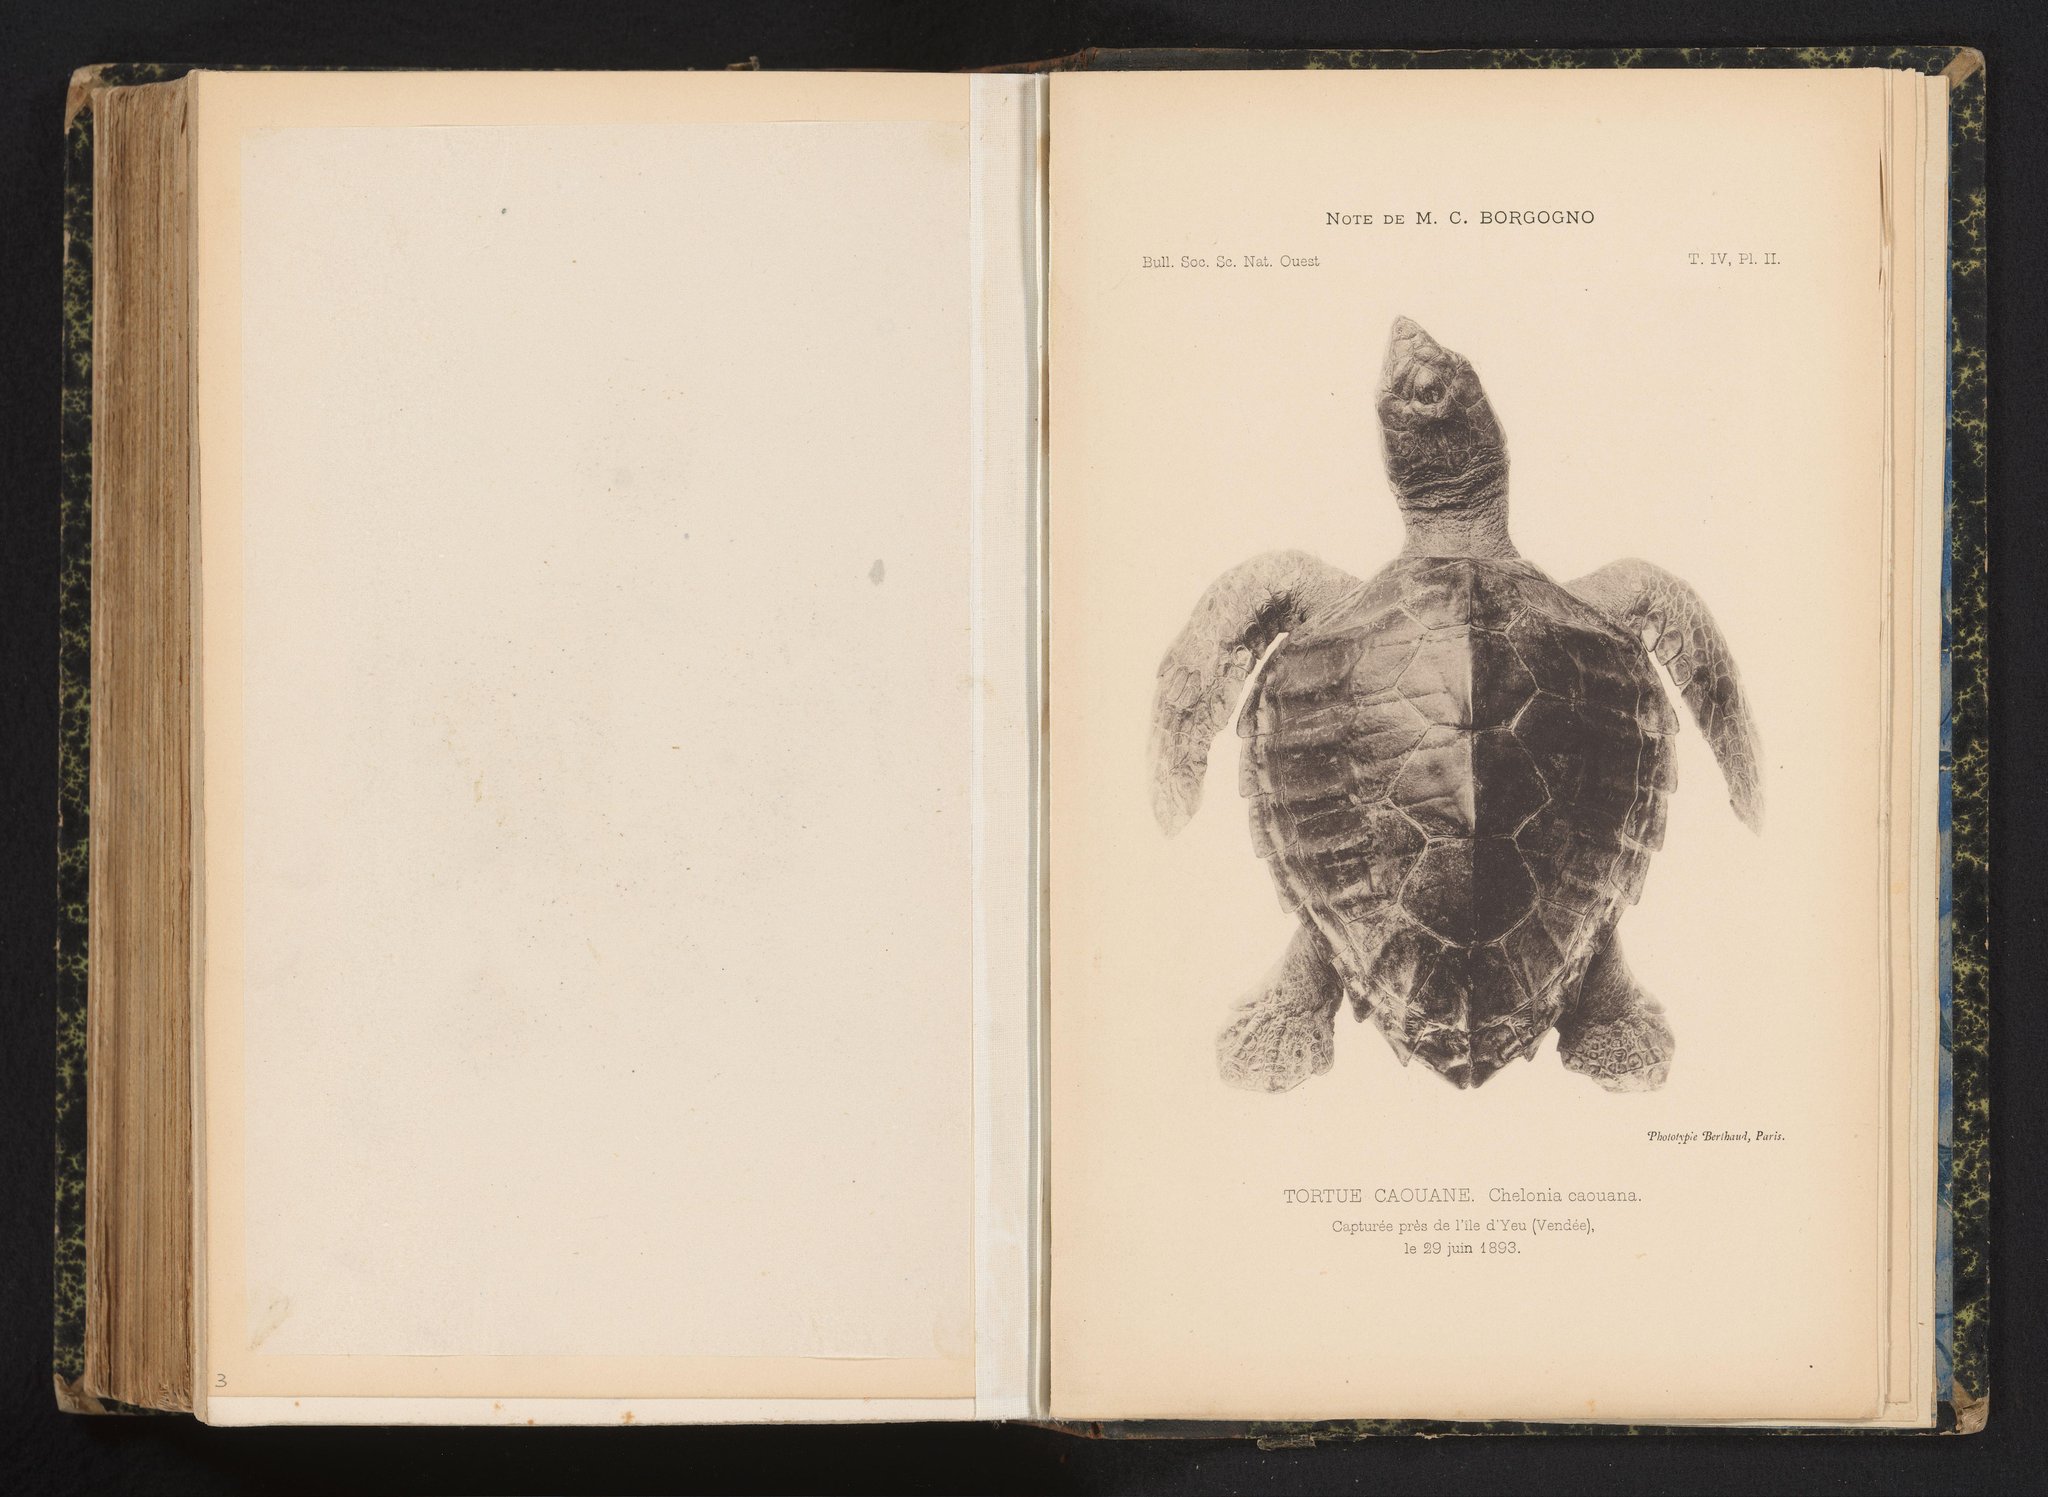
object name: page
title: Caretta schildpad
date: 1888-1893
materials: paper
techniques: photograph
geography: paris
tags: tortoises, turtles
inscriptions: inscription: ‘Chelonia caouana./ Capturée près de l'île d'Yeu (Vendée),/ le 29 juin 1893.’, inscription: ‘Note de M. C. BORGOGNO’, number: ‘T. IV, Pl. II.’